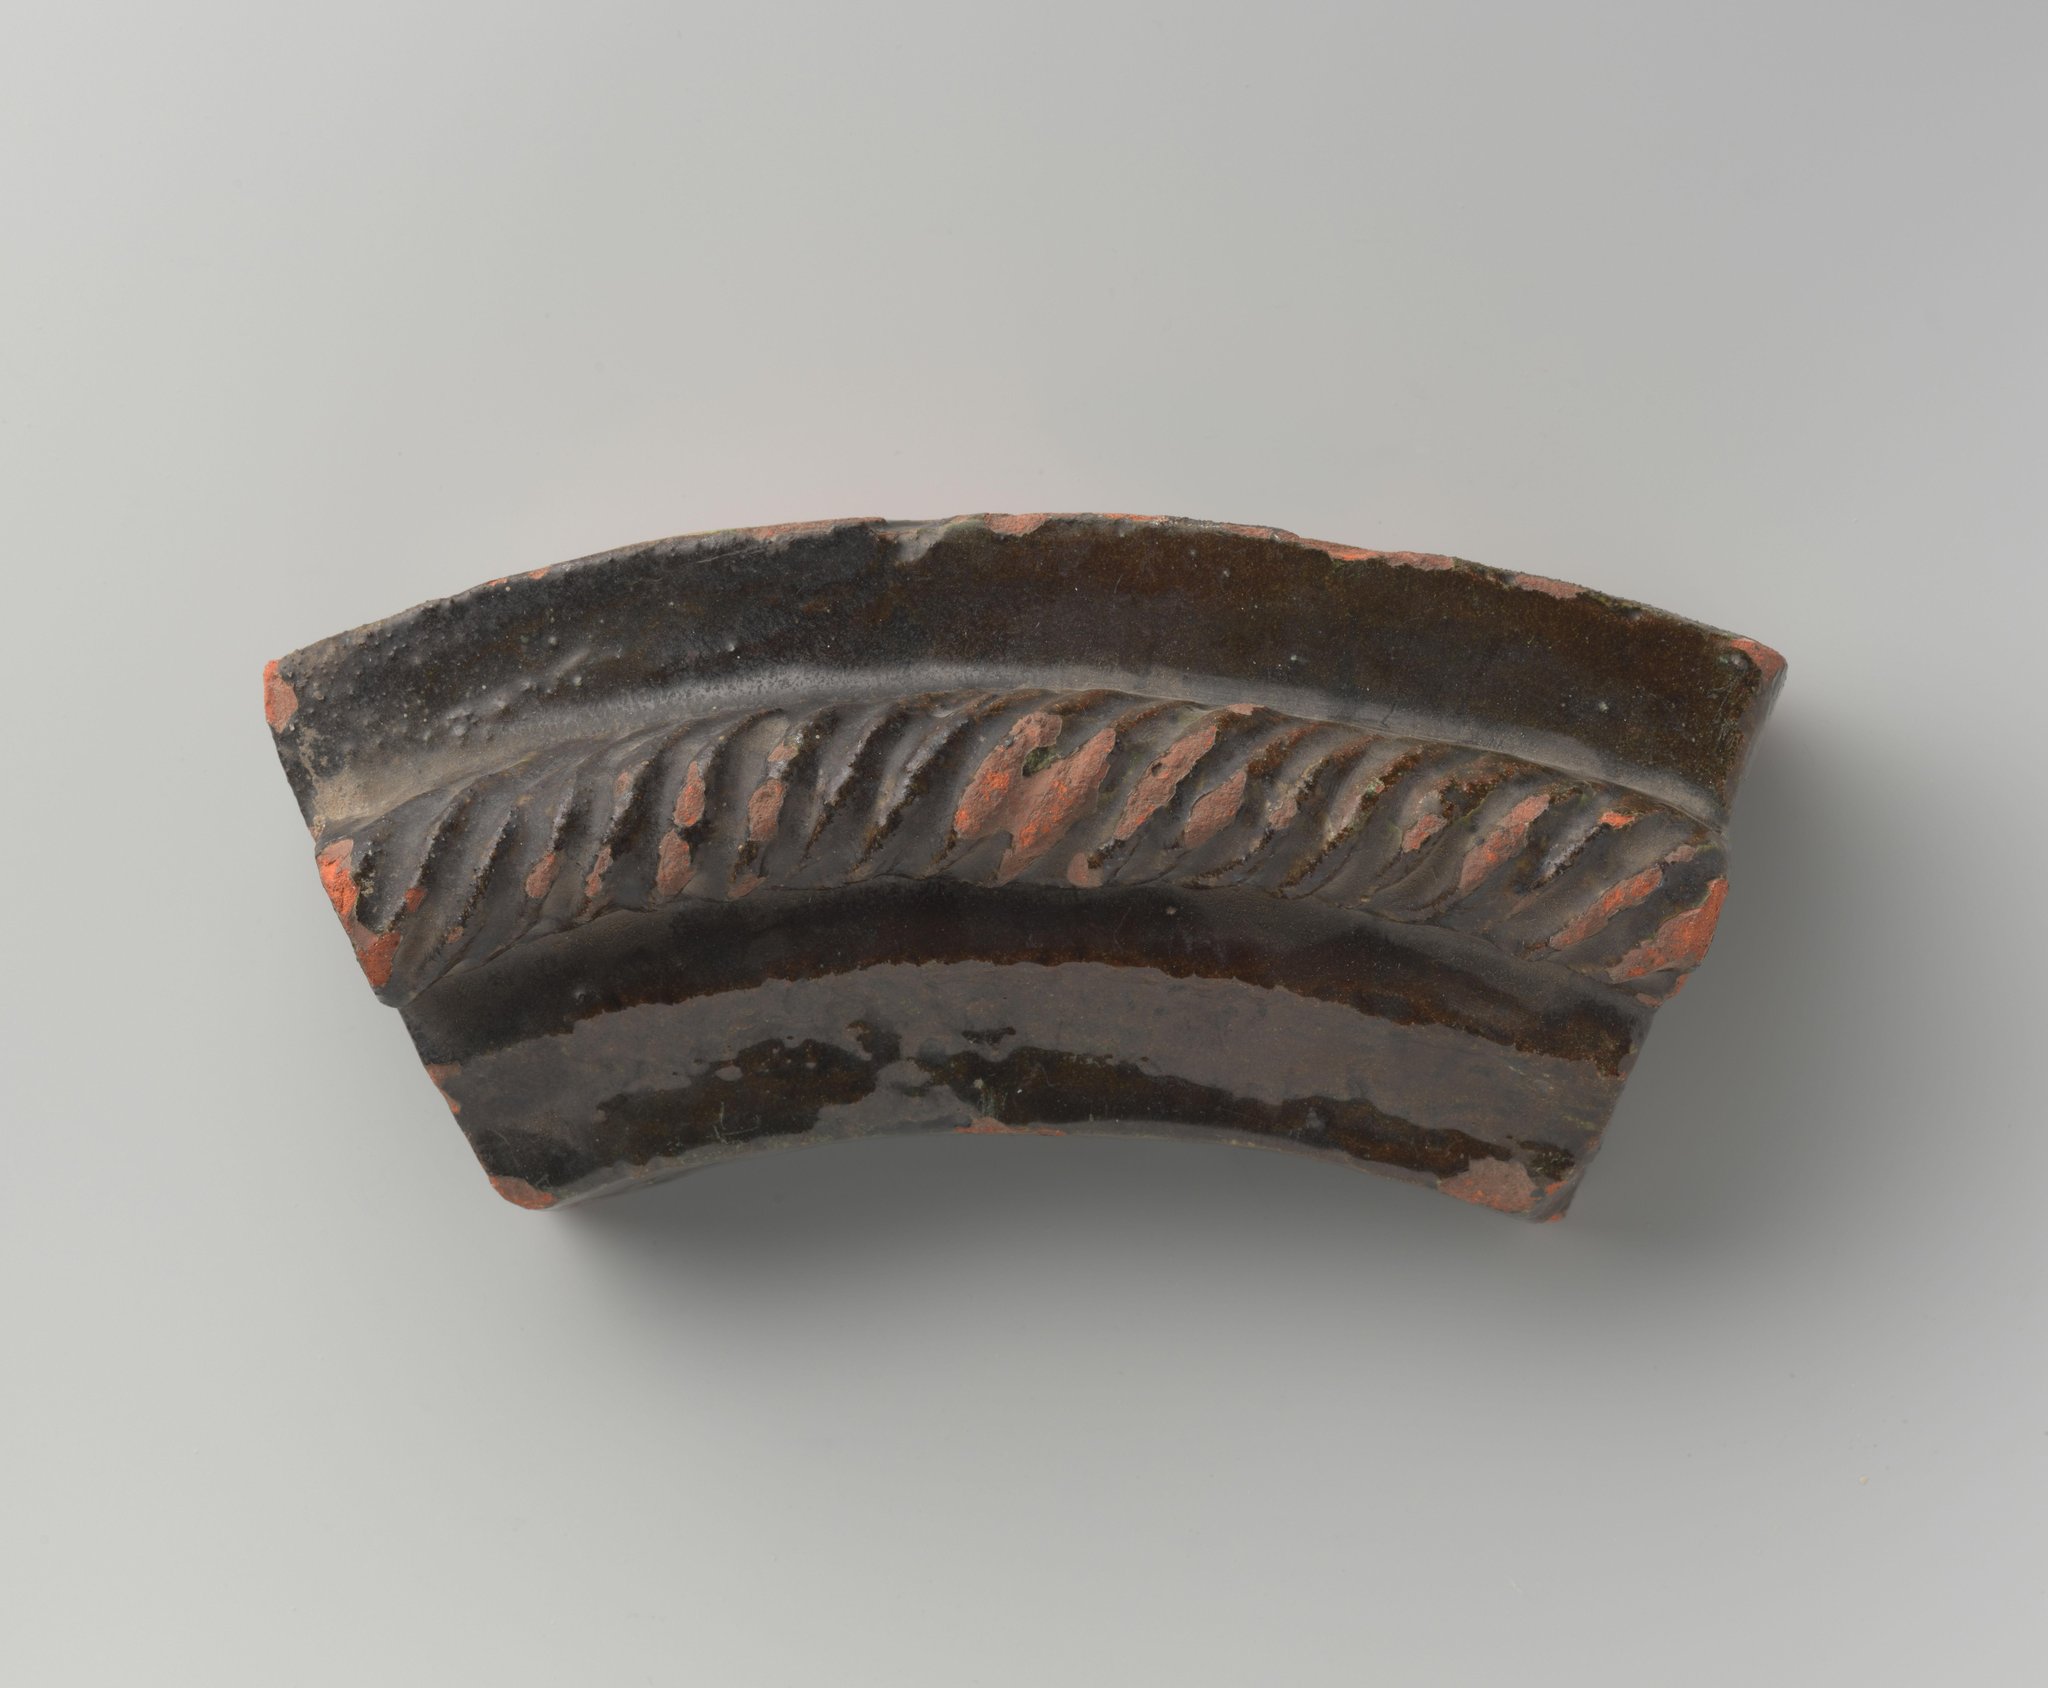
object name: brick clay product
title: Baksteen, afkomstig van de abdij te Aduard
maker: Anonymous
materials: brick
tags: aduard abbey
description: Gave baksteen, in de vorm van een cirkel-segment, aan één van de lange kanten concaaf afgerond. De bovenkant en één van de lange zijkanten geheel bedekt met dik opgelegd donkerbruin loodglazuur, waarin sporen van groen. Het glazuur is aan de andere kanten op onregelmatige wijze afgedrukt. Afkomstig van de Abdij te Aduard.